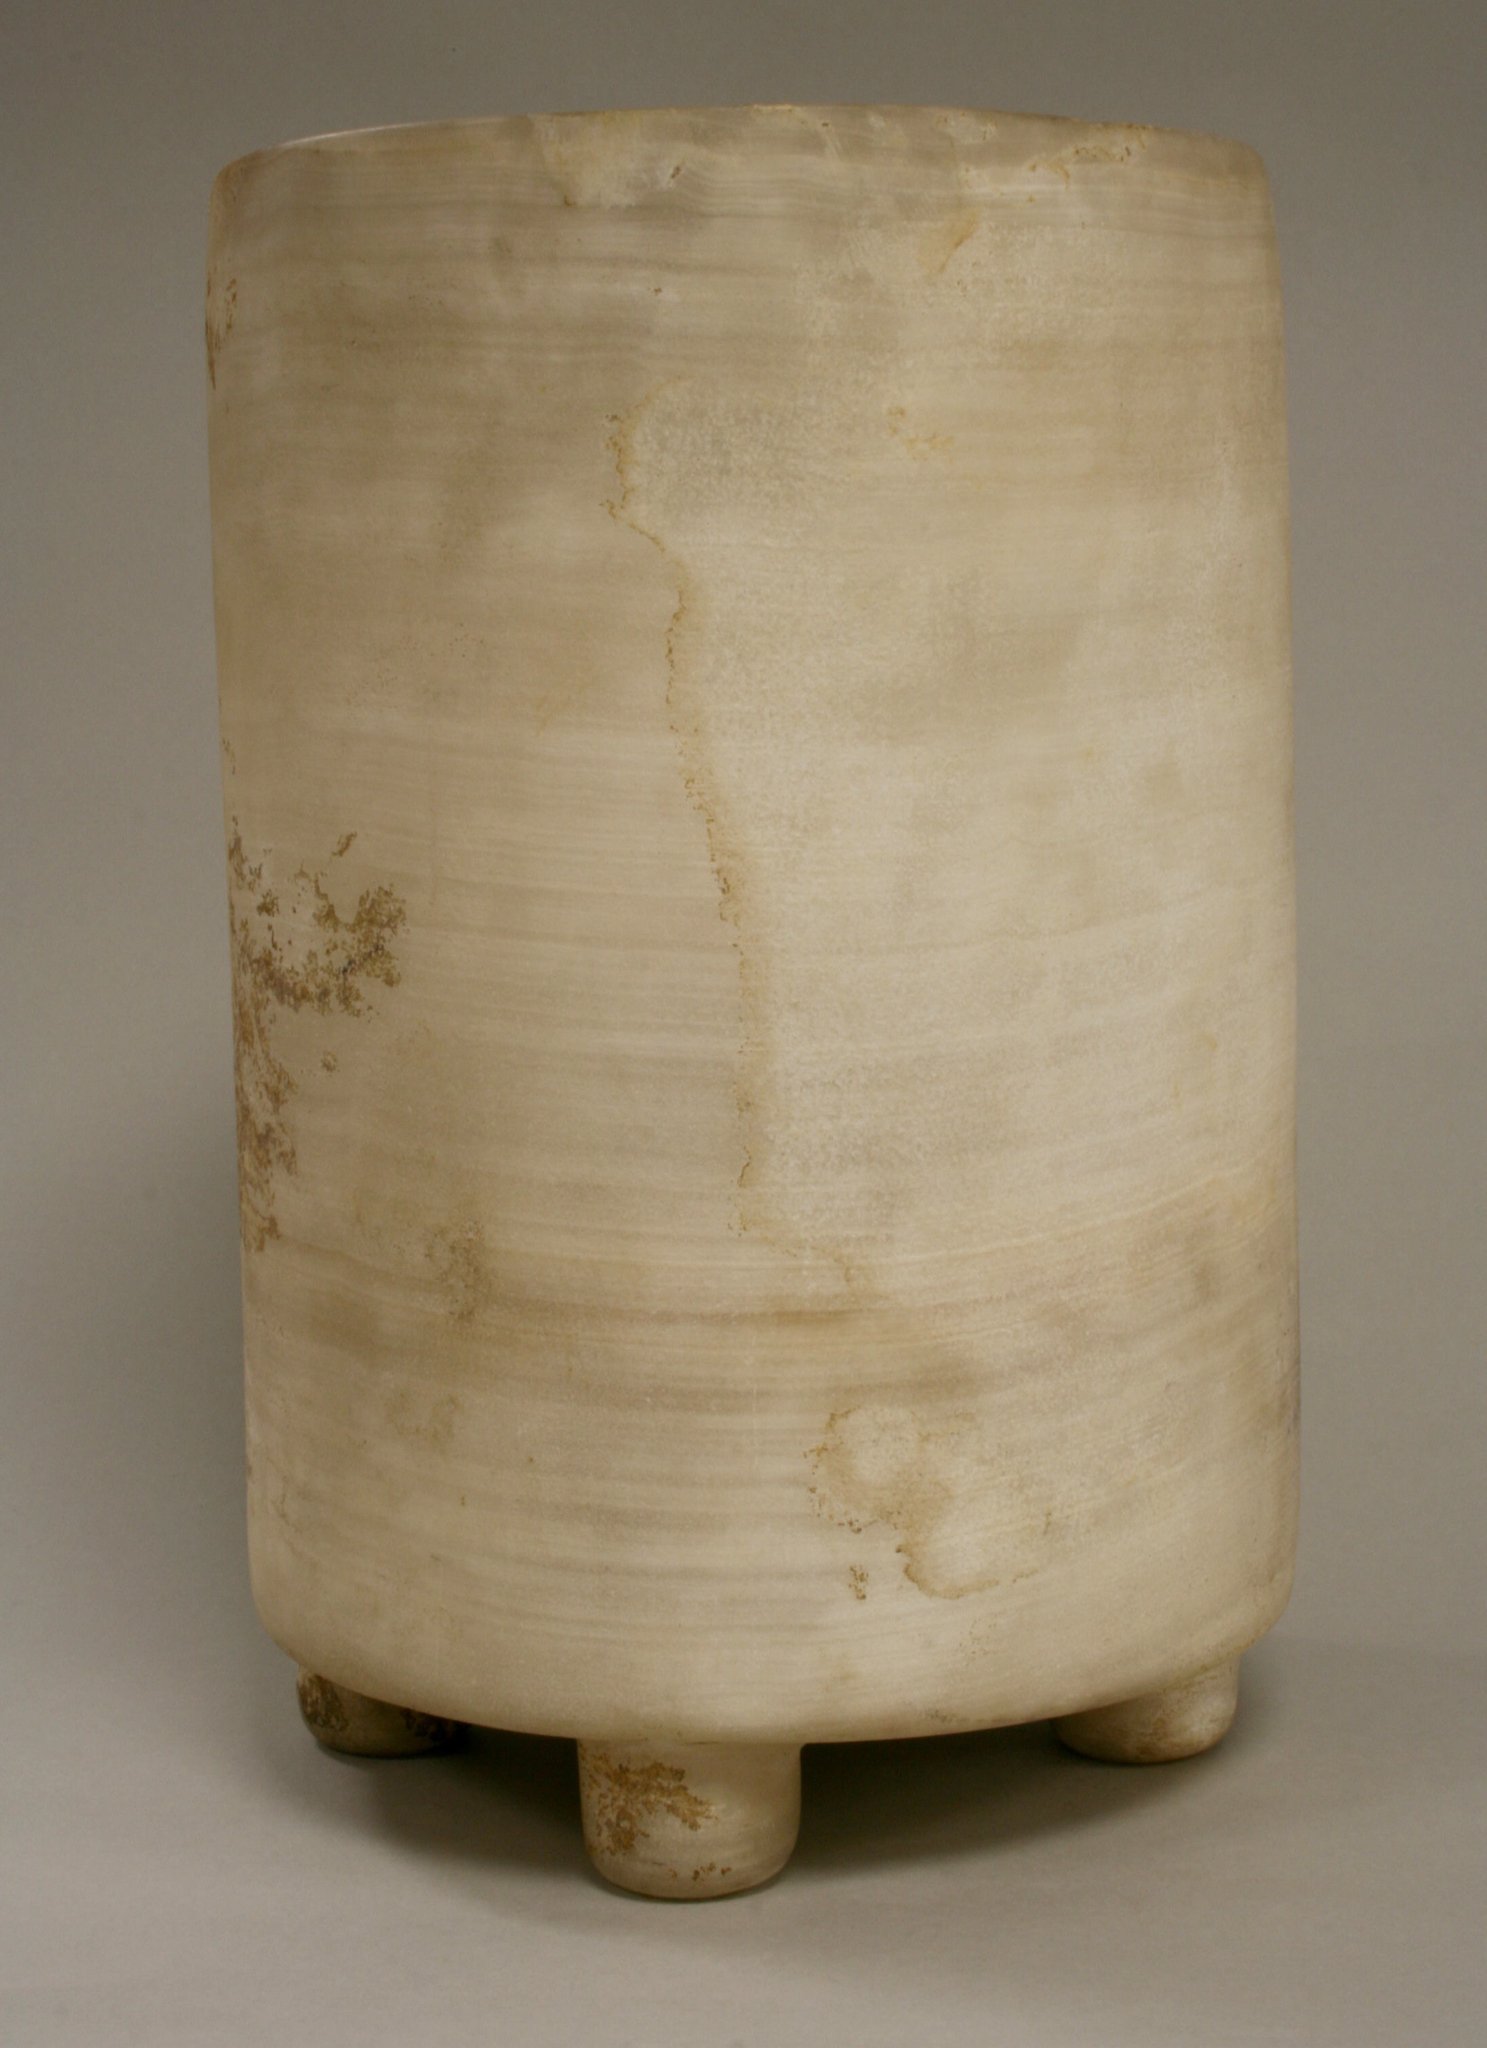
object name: vessel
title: Onyx Vessel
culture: mexican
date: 901-1600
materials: marble, onyx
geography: mexico